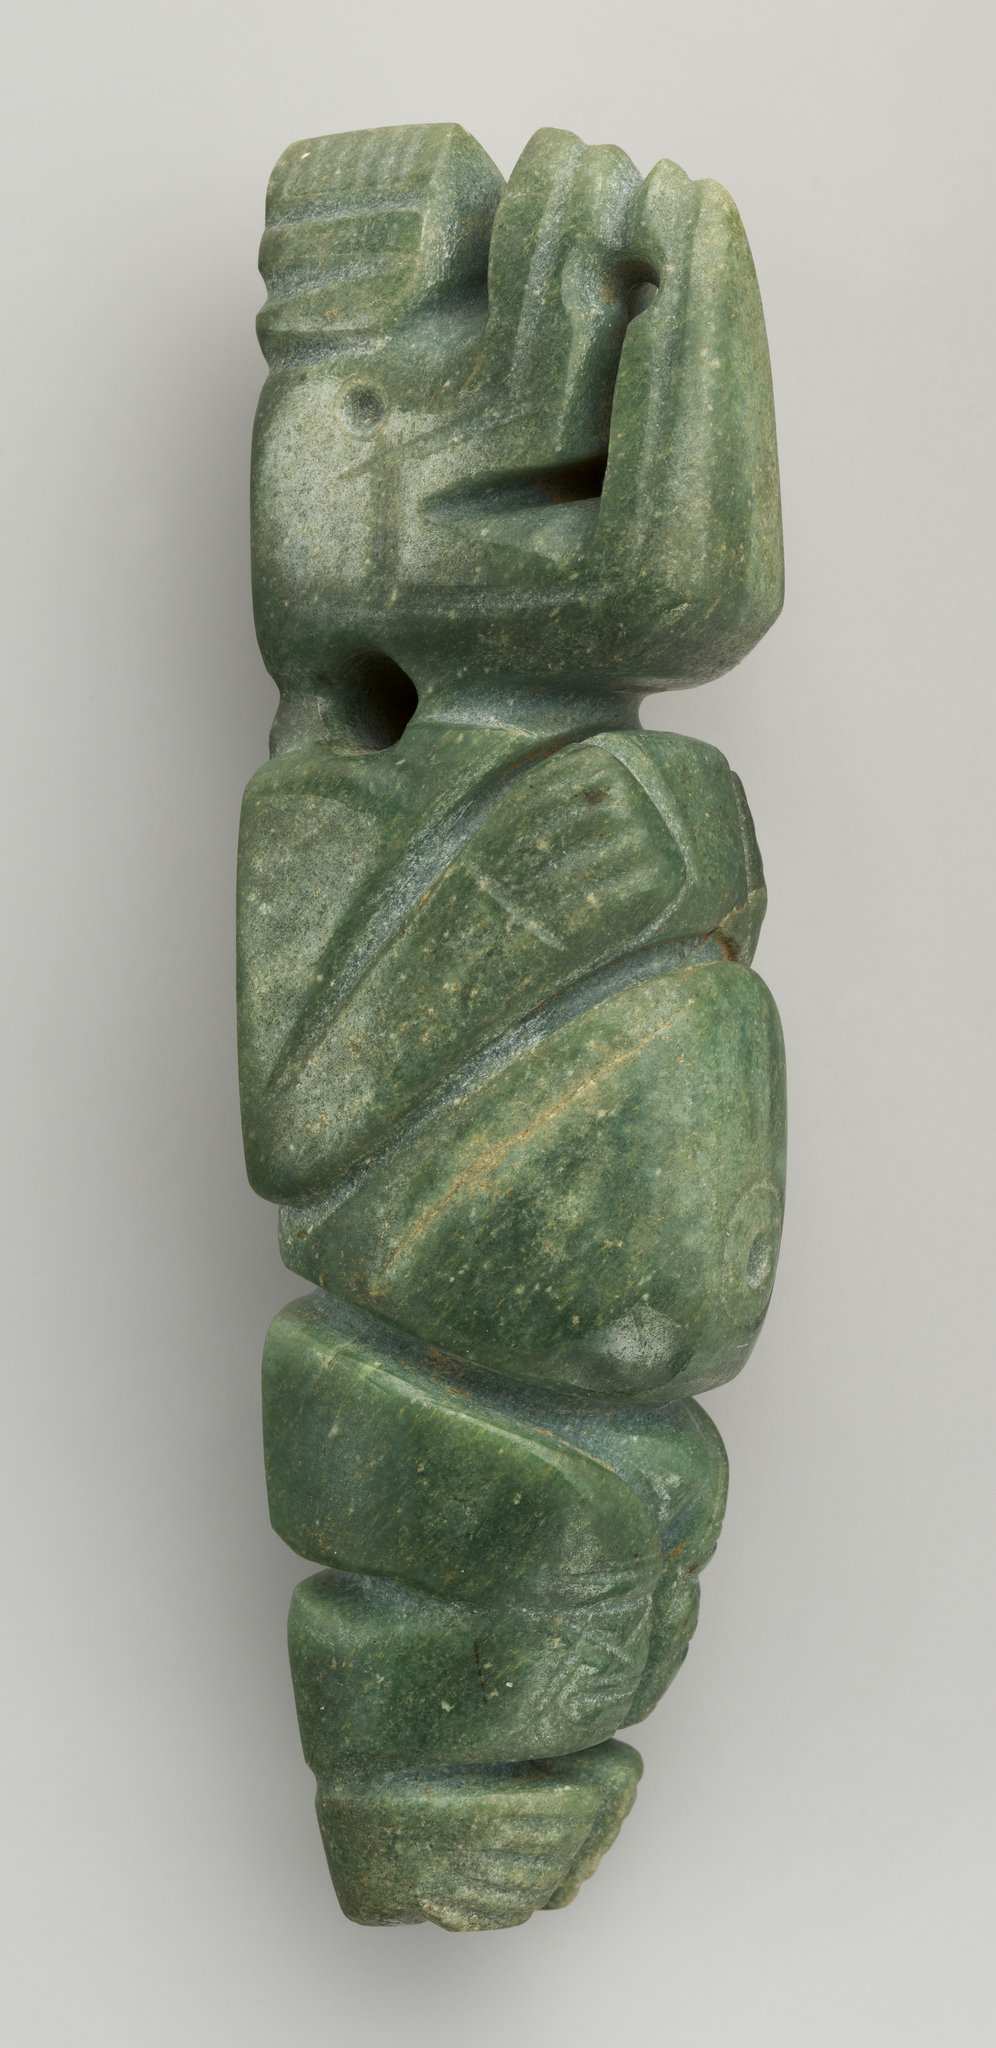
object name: pendant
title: Masked Figure Pendant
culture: atlantic watershed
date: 301-800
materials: jade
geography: costa rica